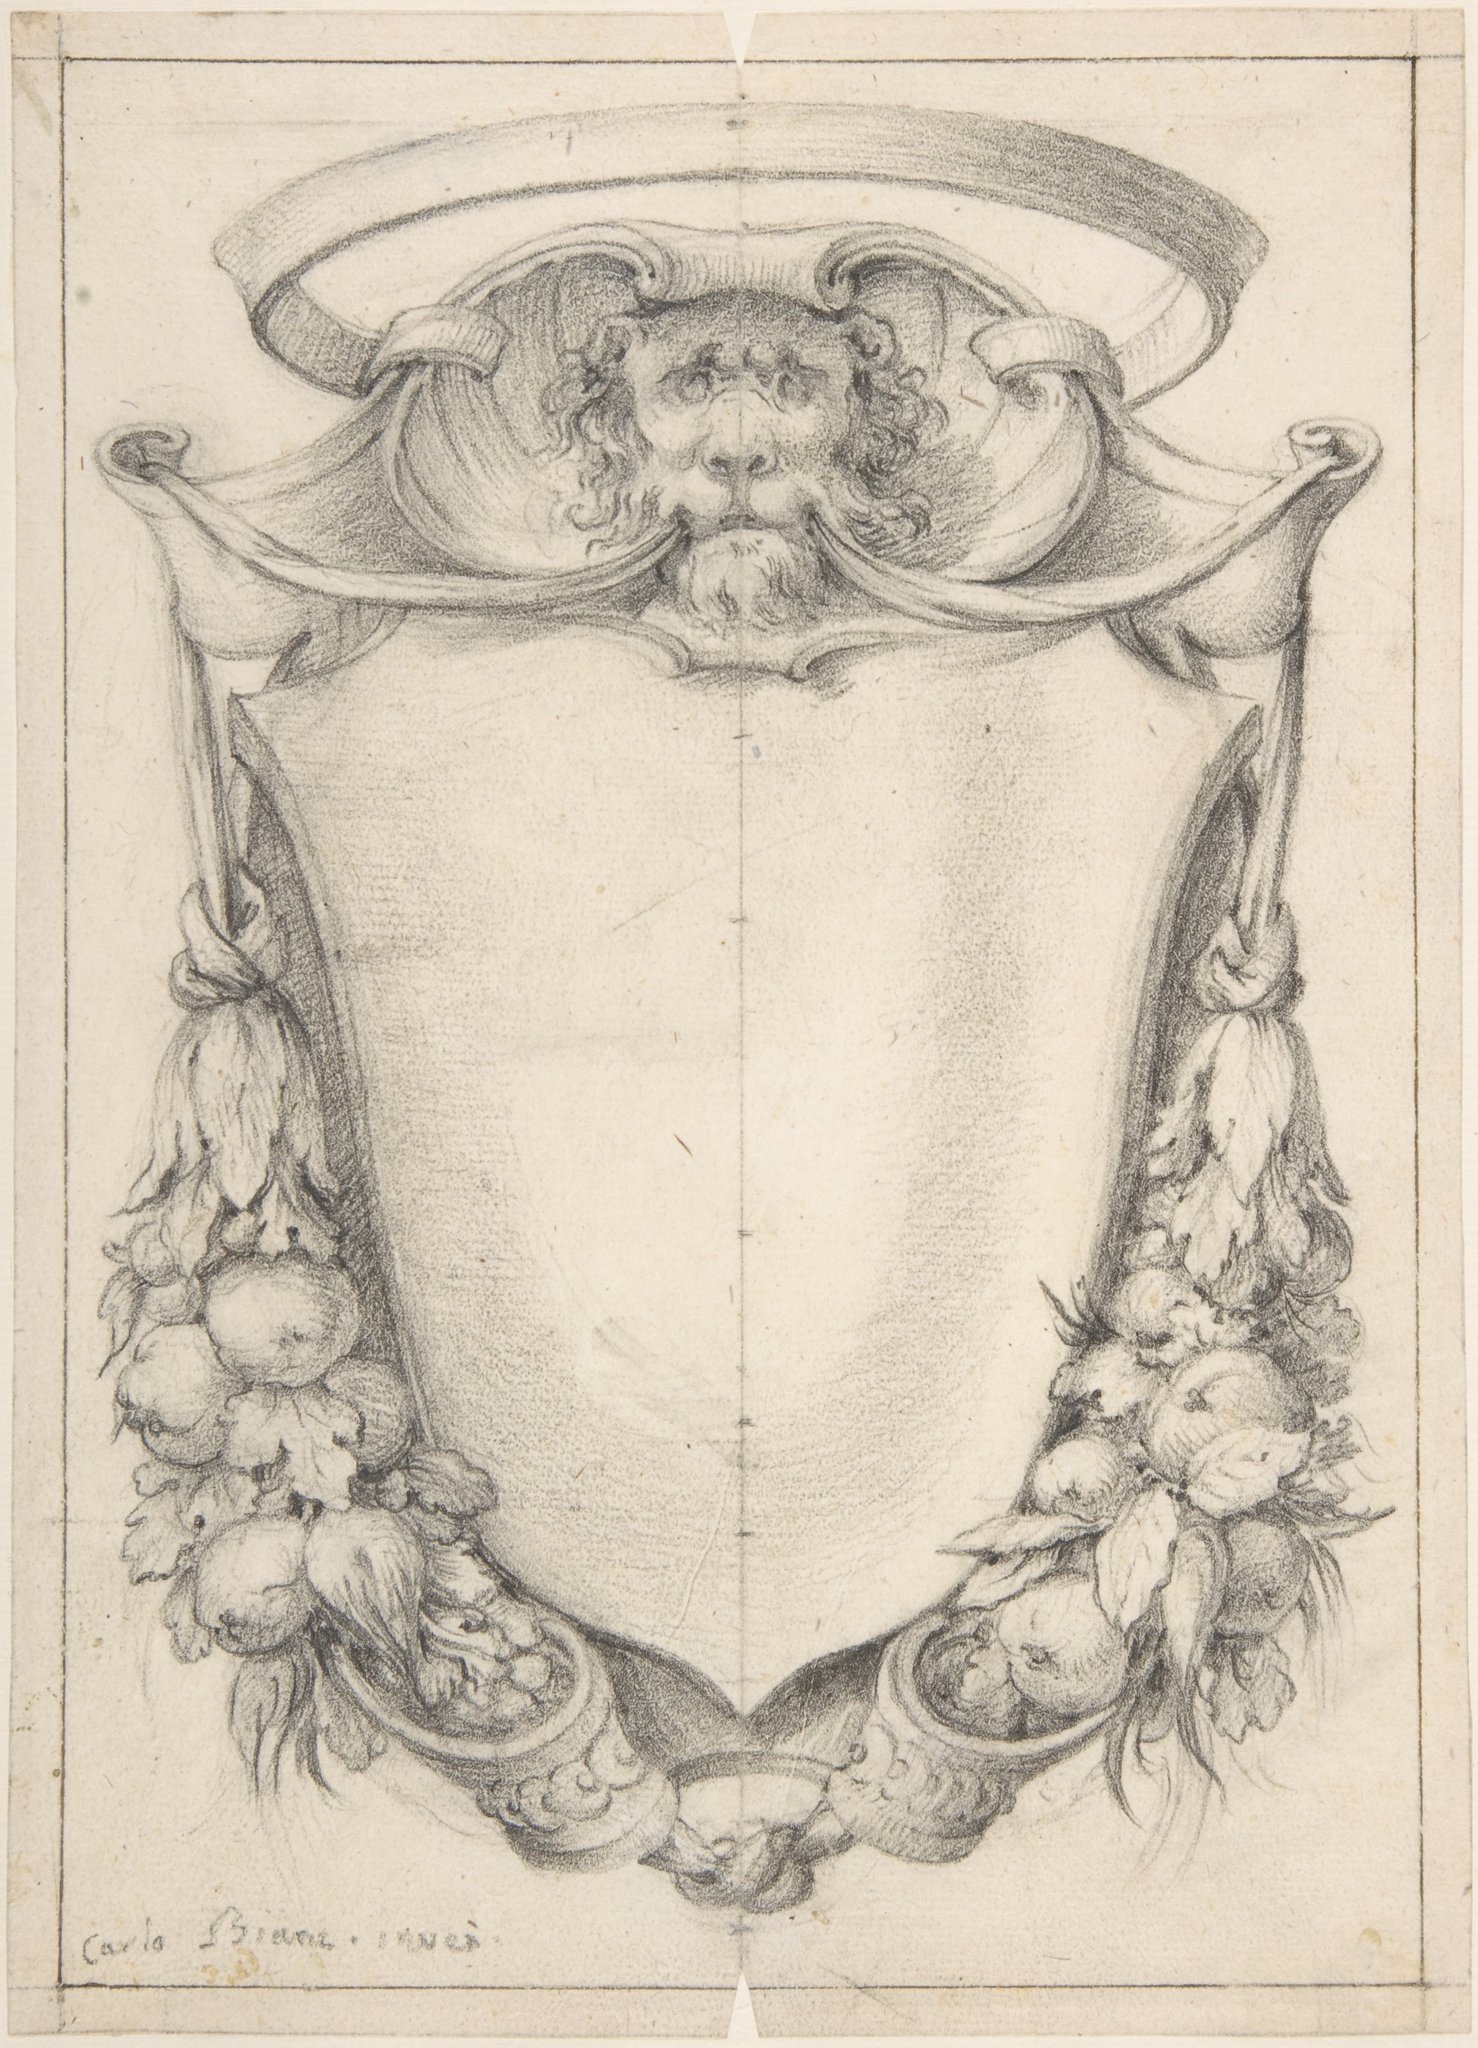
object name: drawing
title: Design for a Cartouche with a Lion's Head and Nimbus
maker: carlo bianconi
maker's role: artist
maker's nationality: italian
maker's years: 1732-1802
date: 1752-1802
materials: ink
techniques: brush, pen, wash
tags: cartouches,fruit,lions,leaves